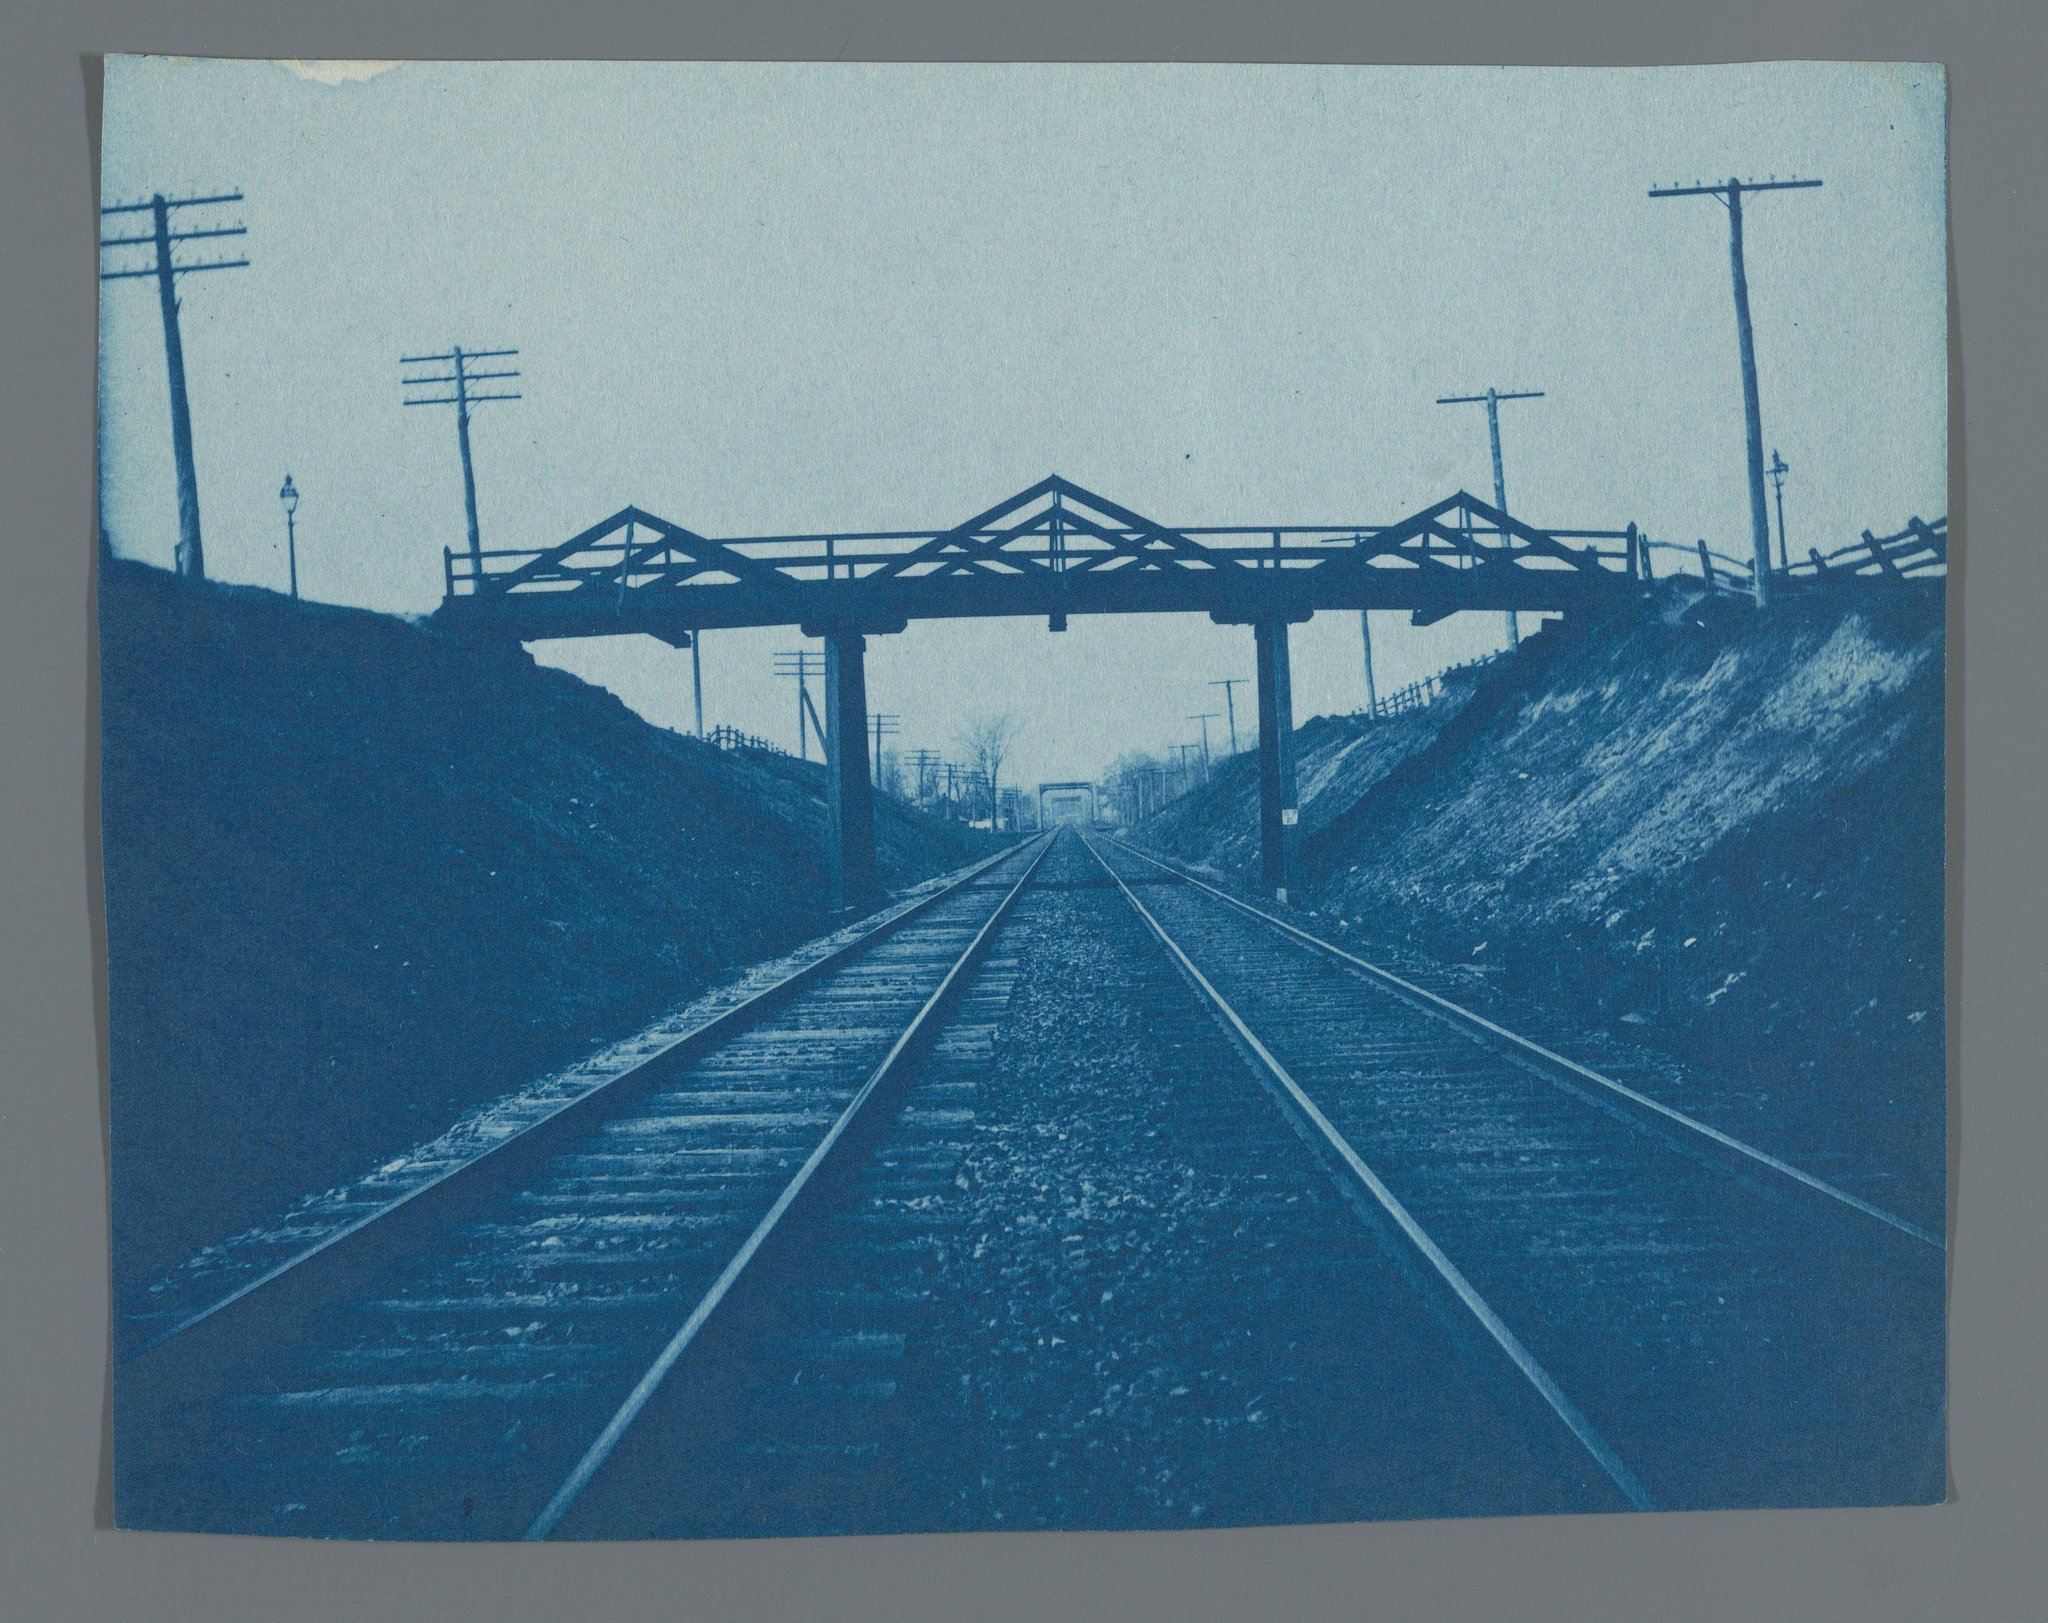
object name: photograph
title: Aanleg spoorbruggen, Verenigde Staten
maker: Anonymous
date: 1900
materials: paper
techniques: cyanotype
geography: united states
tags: railway, tramway; rack railway, bridge, united states of america